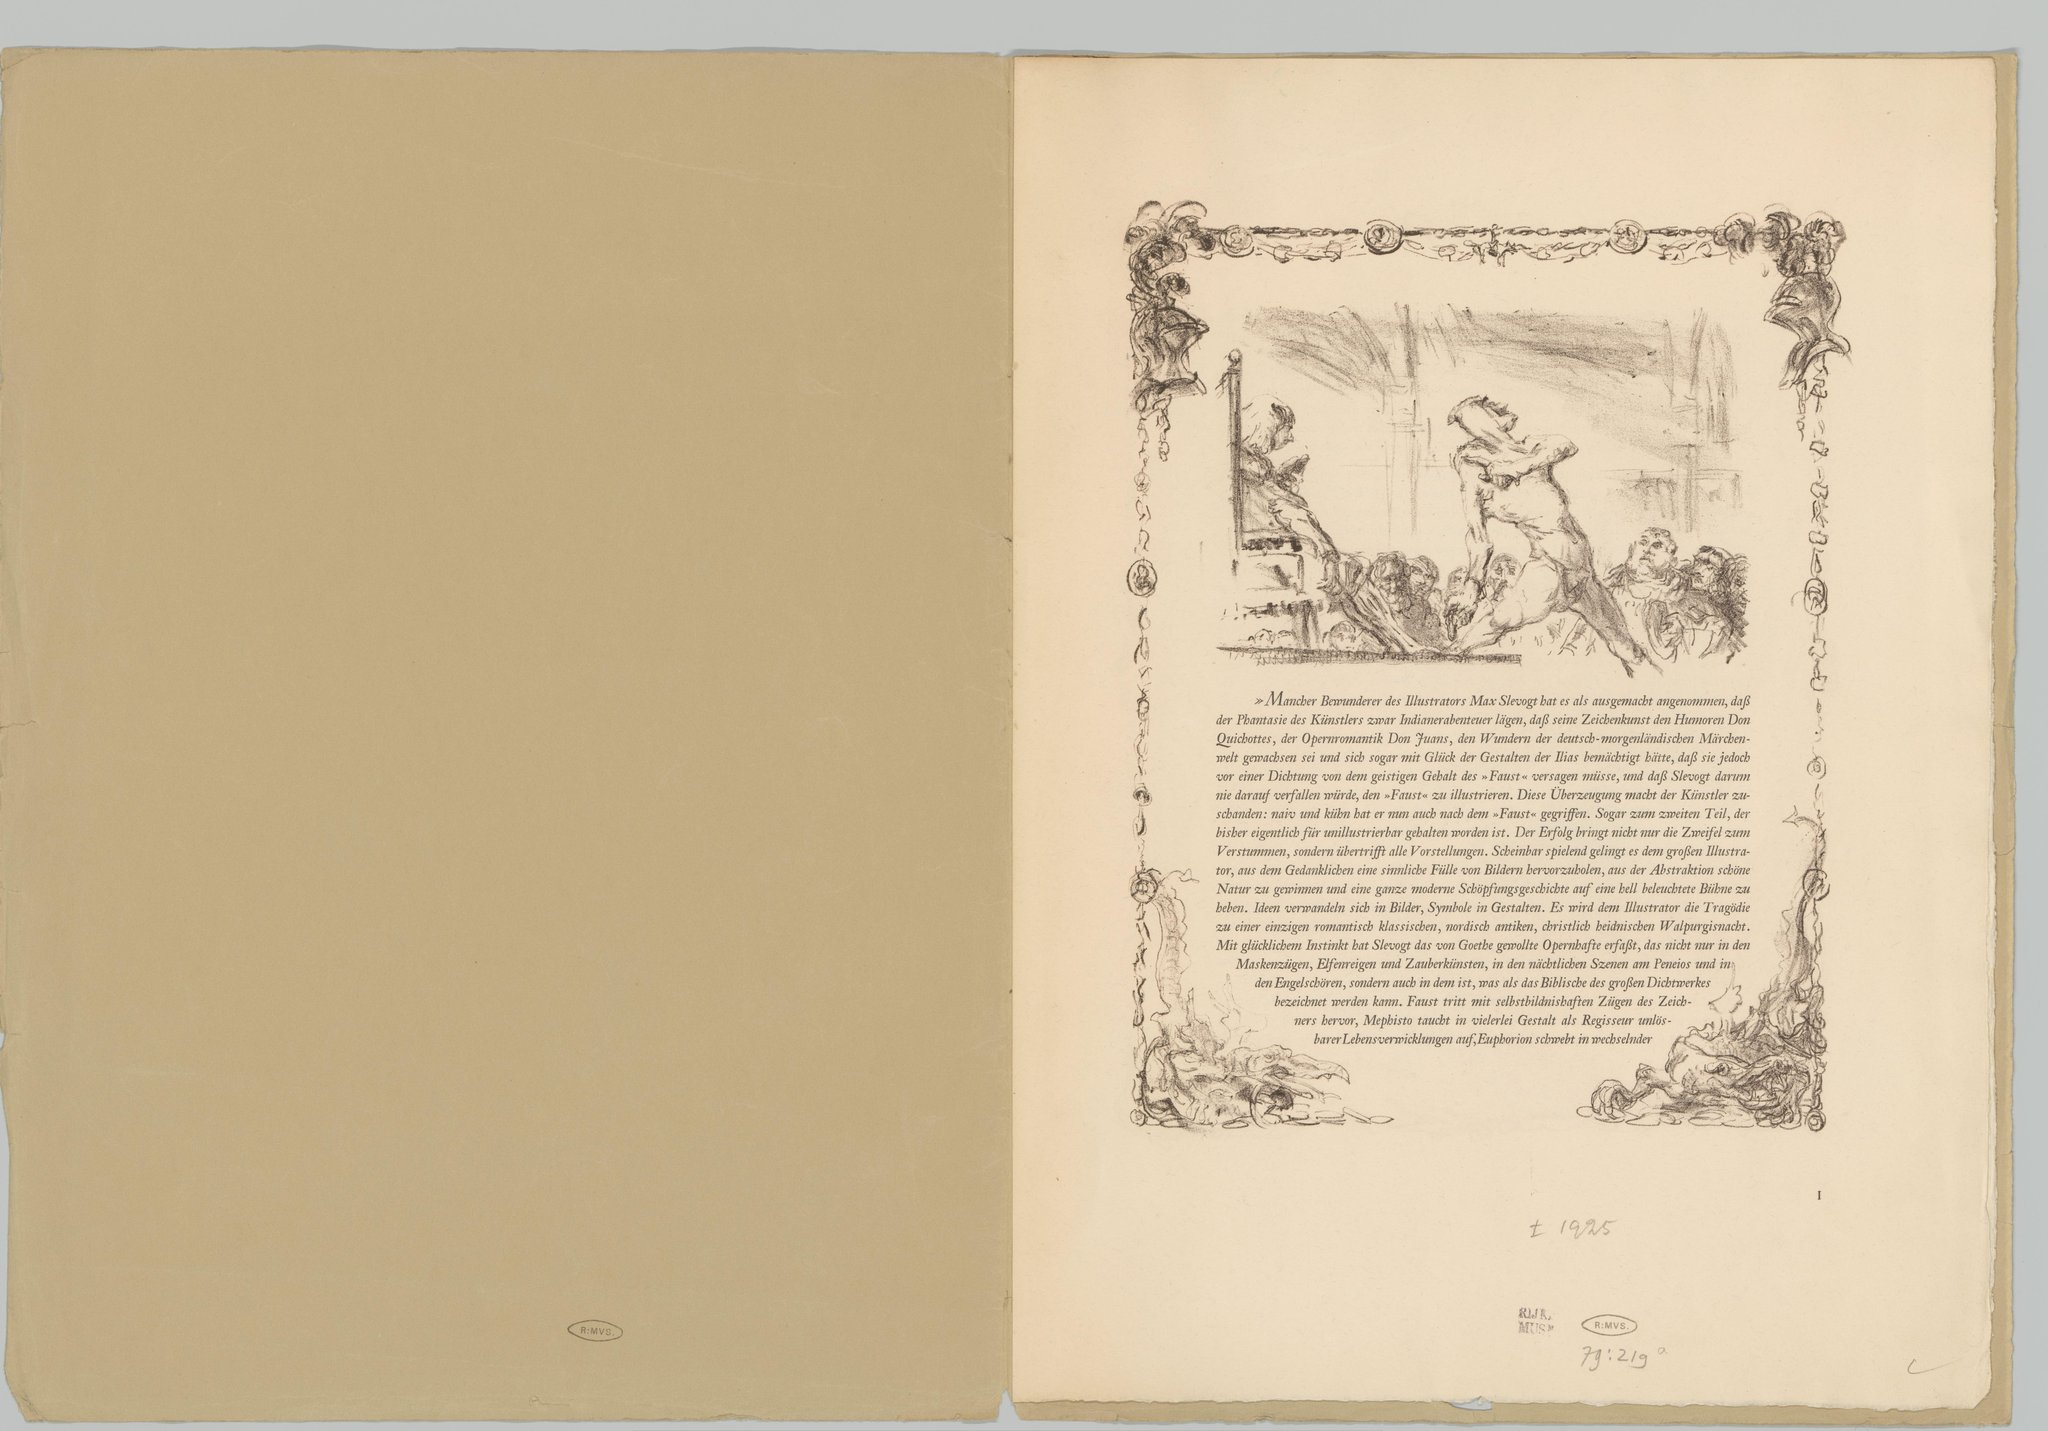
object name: print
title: Faust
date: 1925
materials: paper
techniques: letterpress printing, lithograph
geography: berlin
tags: faust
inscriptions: collector's mark: Lugt 2228